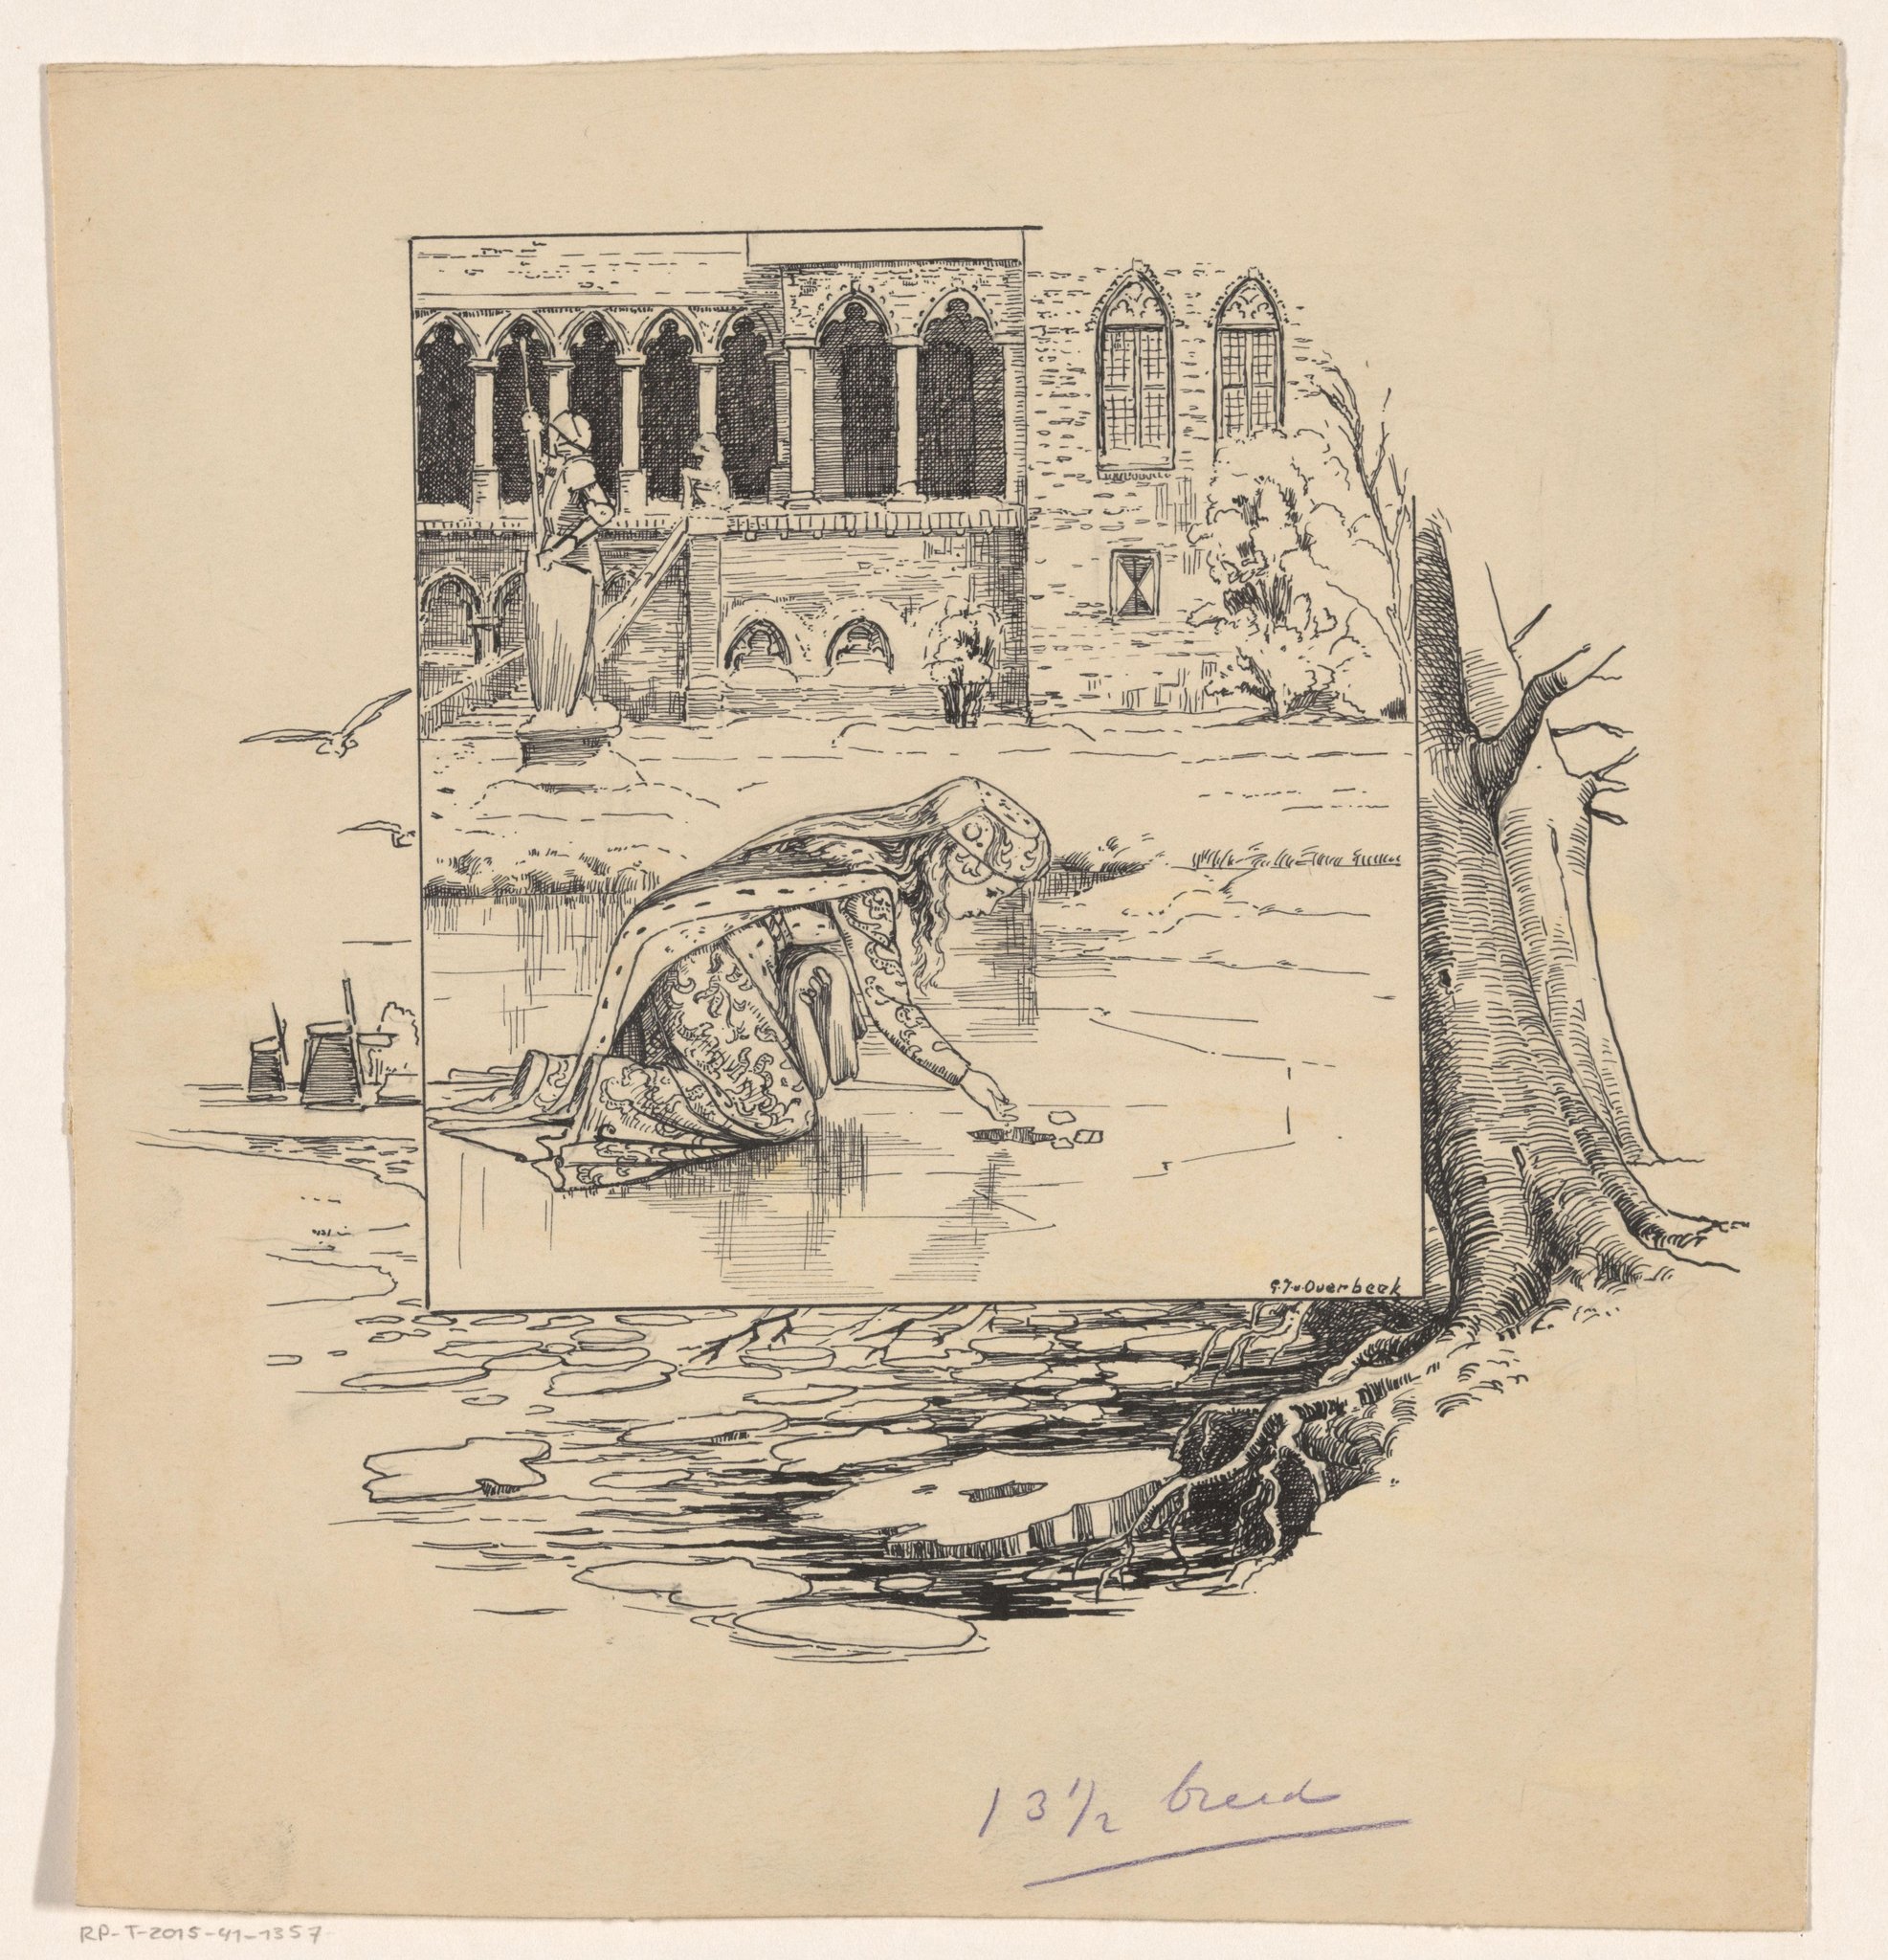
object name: drawing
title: Meisje strooit kruimels in een wak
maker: gijsbertus johannes van overbeek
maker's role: draughtsman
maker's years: 1882-1947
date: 1892-1947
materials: ink, paper, pencil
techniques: pen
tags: kneeling figure - aa - female human figure, feeding wild animals in winter, windmill in landscape, ice ~ state of water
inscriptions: :, signature: ‘G.J. v. Overbeek’, collector's mark: Lugt 2228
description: Een rijk gekleed meisje knielt op een bevroren vijver. Ze heeft een wak gemaakt in het ijs en strooit daar kruimels in. Achter haar is een gebouw met een zuilengalerij te zien. Op een tweede tekening achter deze voorstelling een landschap met bomen en molens aan het water. Op het water liggen resten van ijs.